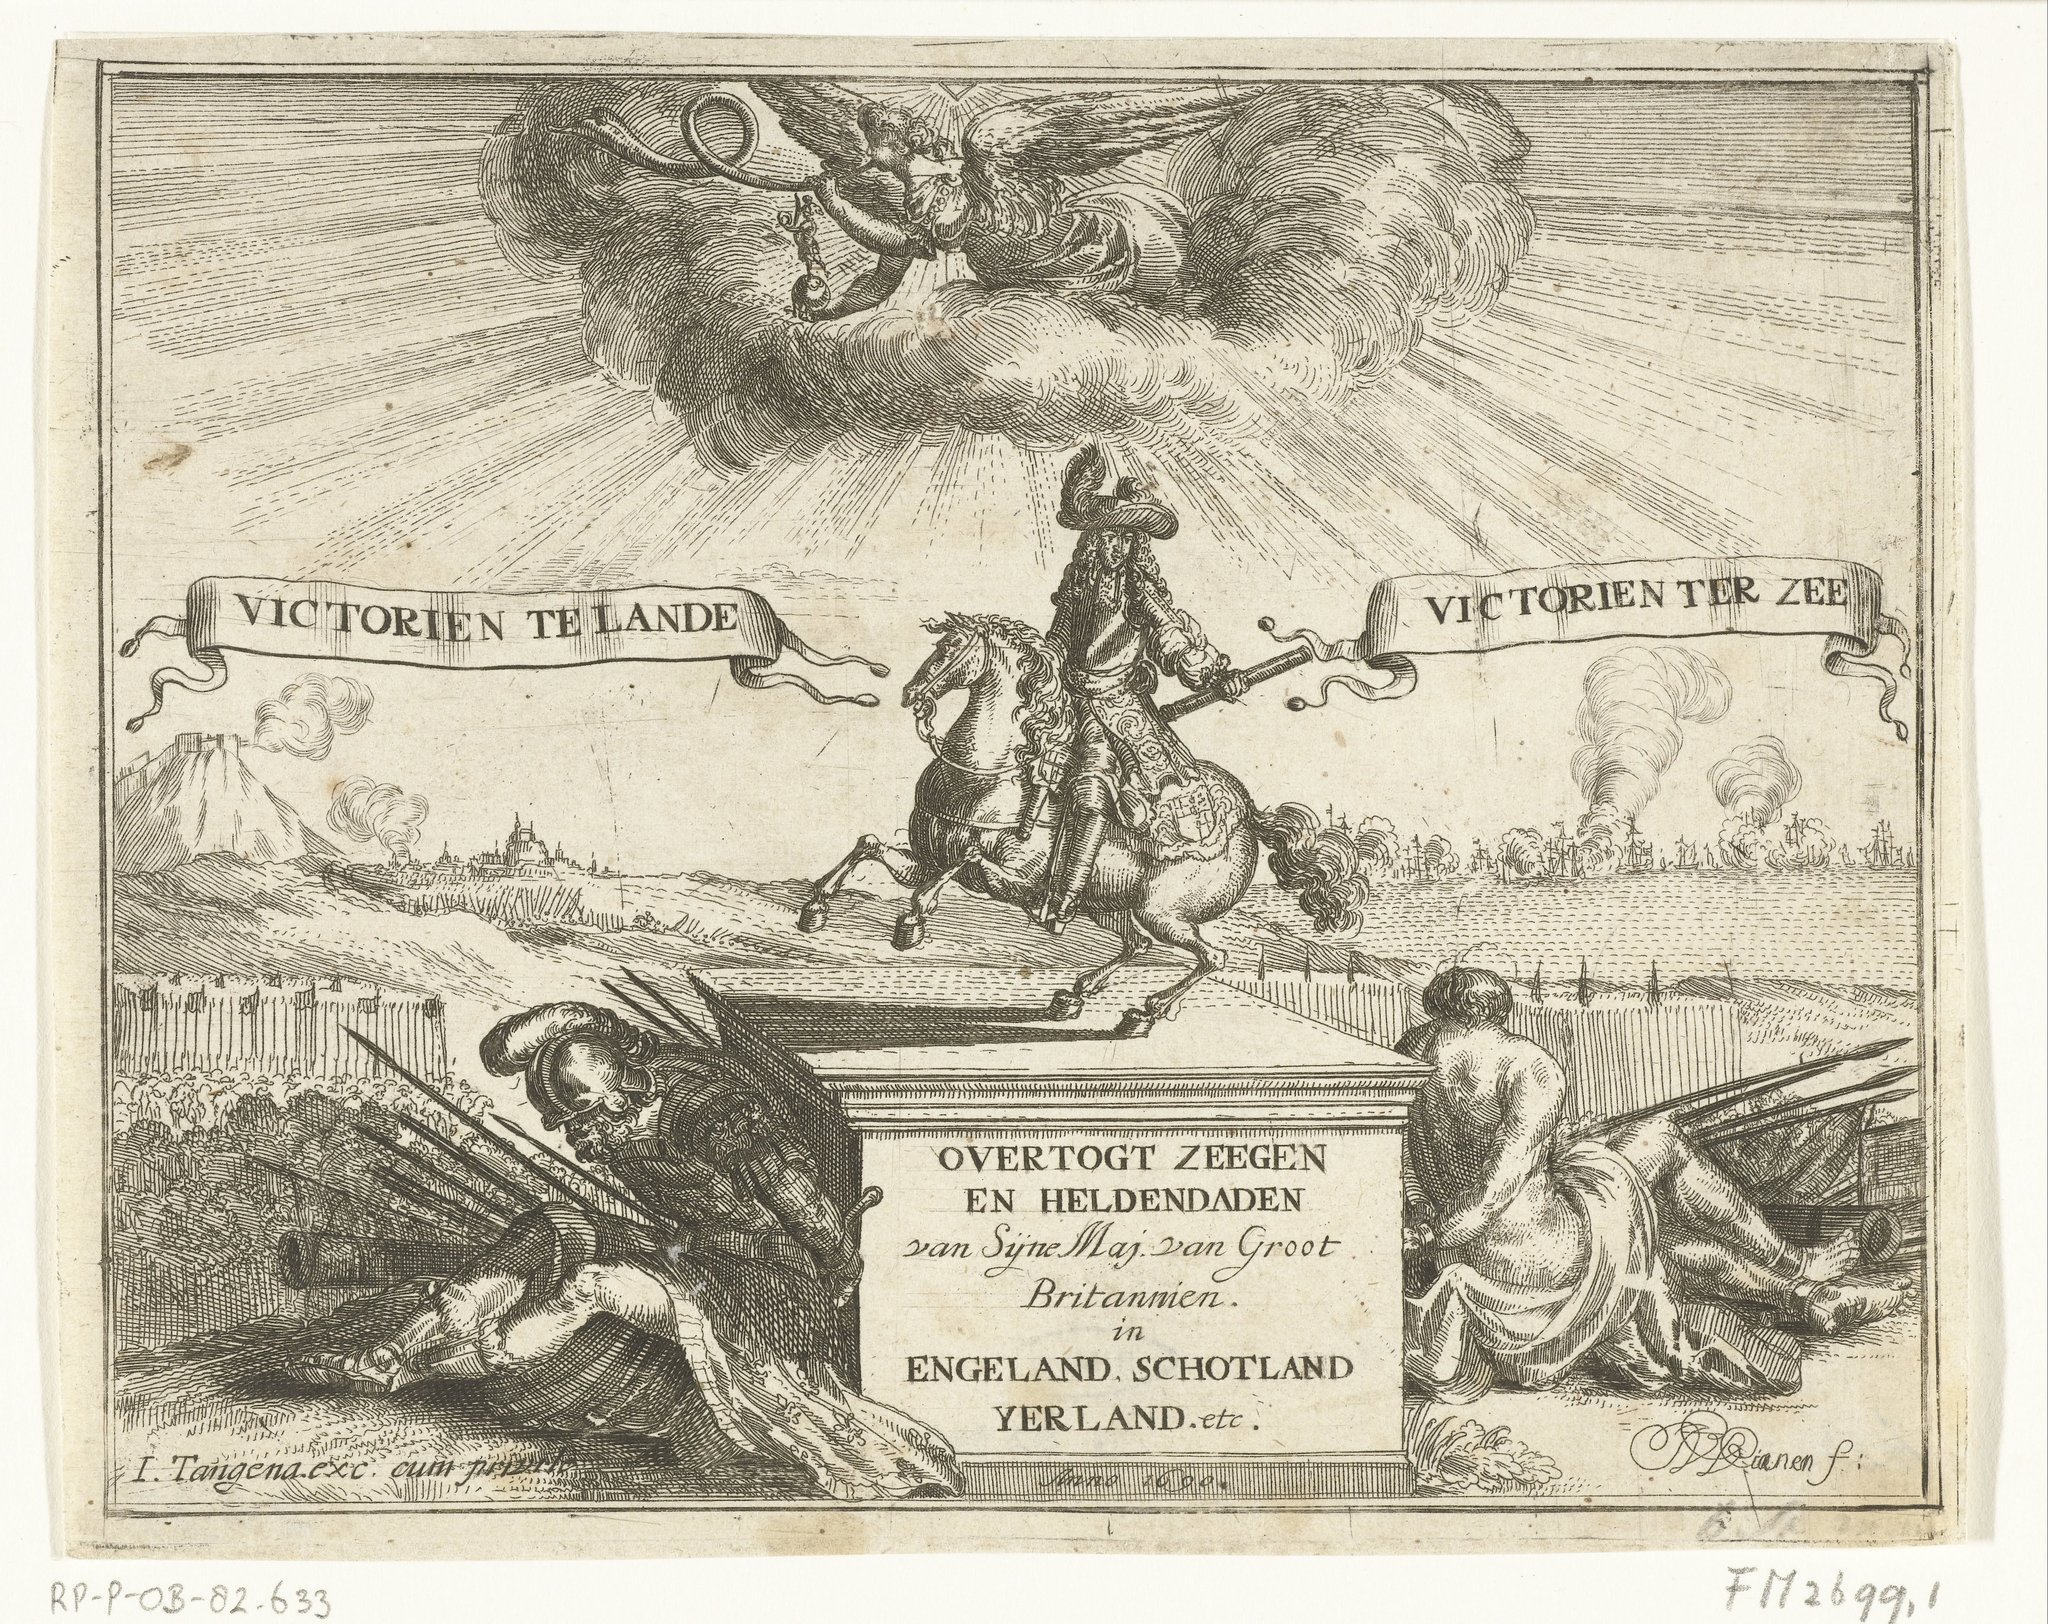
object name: print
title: Victorien te Lande / Victorien ter Zee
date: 1690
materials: paper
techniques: etching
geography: northern netherlands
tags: the hague, william iii (prince of orange and king of england, scotland, and ireland), fame; 'fama', 'fama buona', 'fama chiara' (ripa)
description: Ruiterstandbeeld van koning Willem III op voetstuk, op de grond de overwonnen en geketende vijanden, in de lucht de Faam. Titelprent van een serie van overwinningen van koning Willem III in 1690.